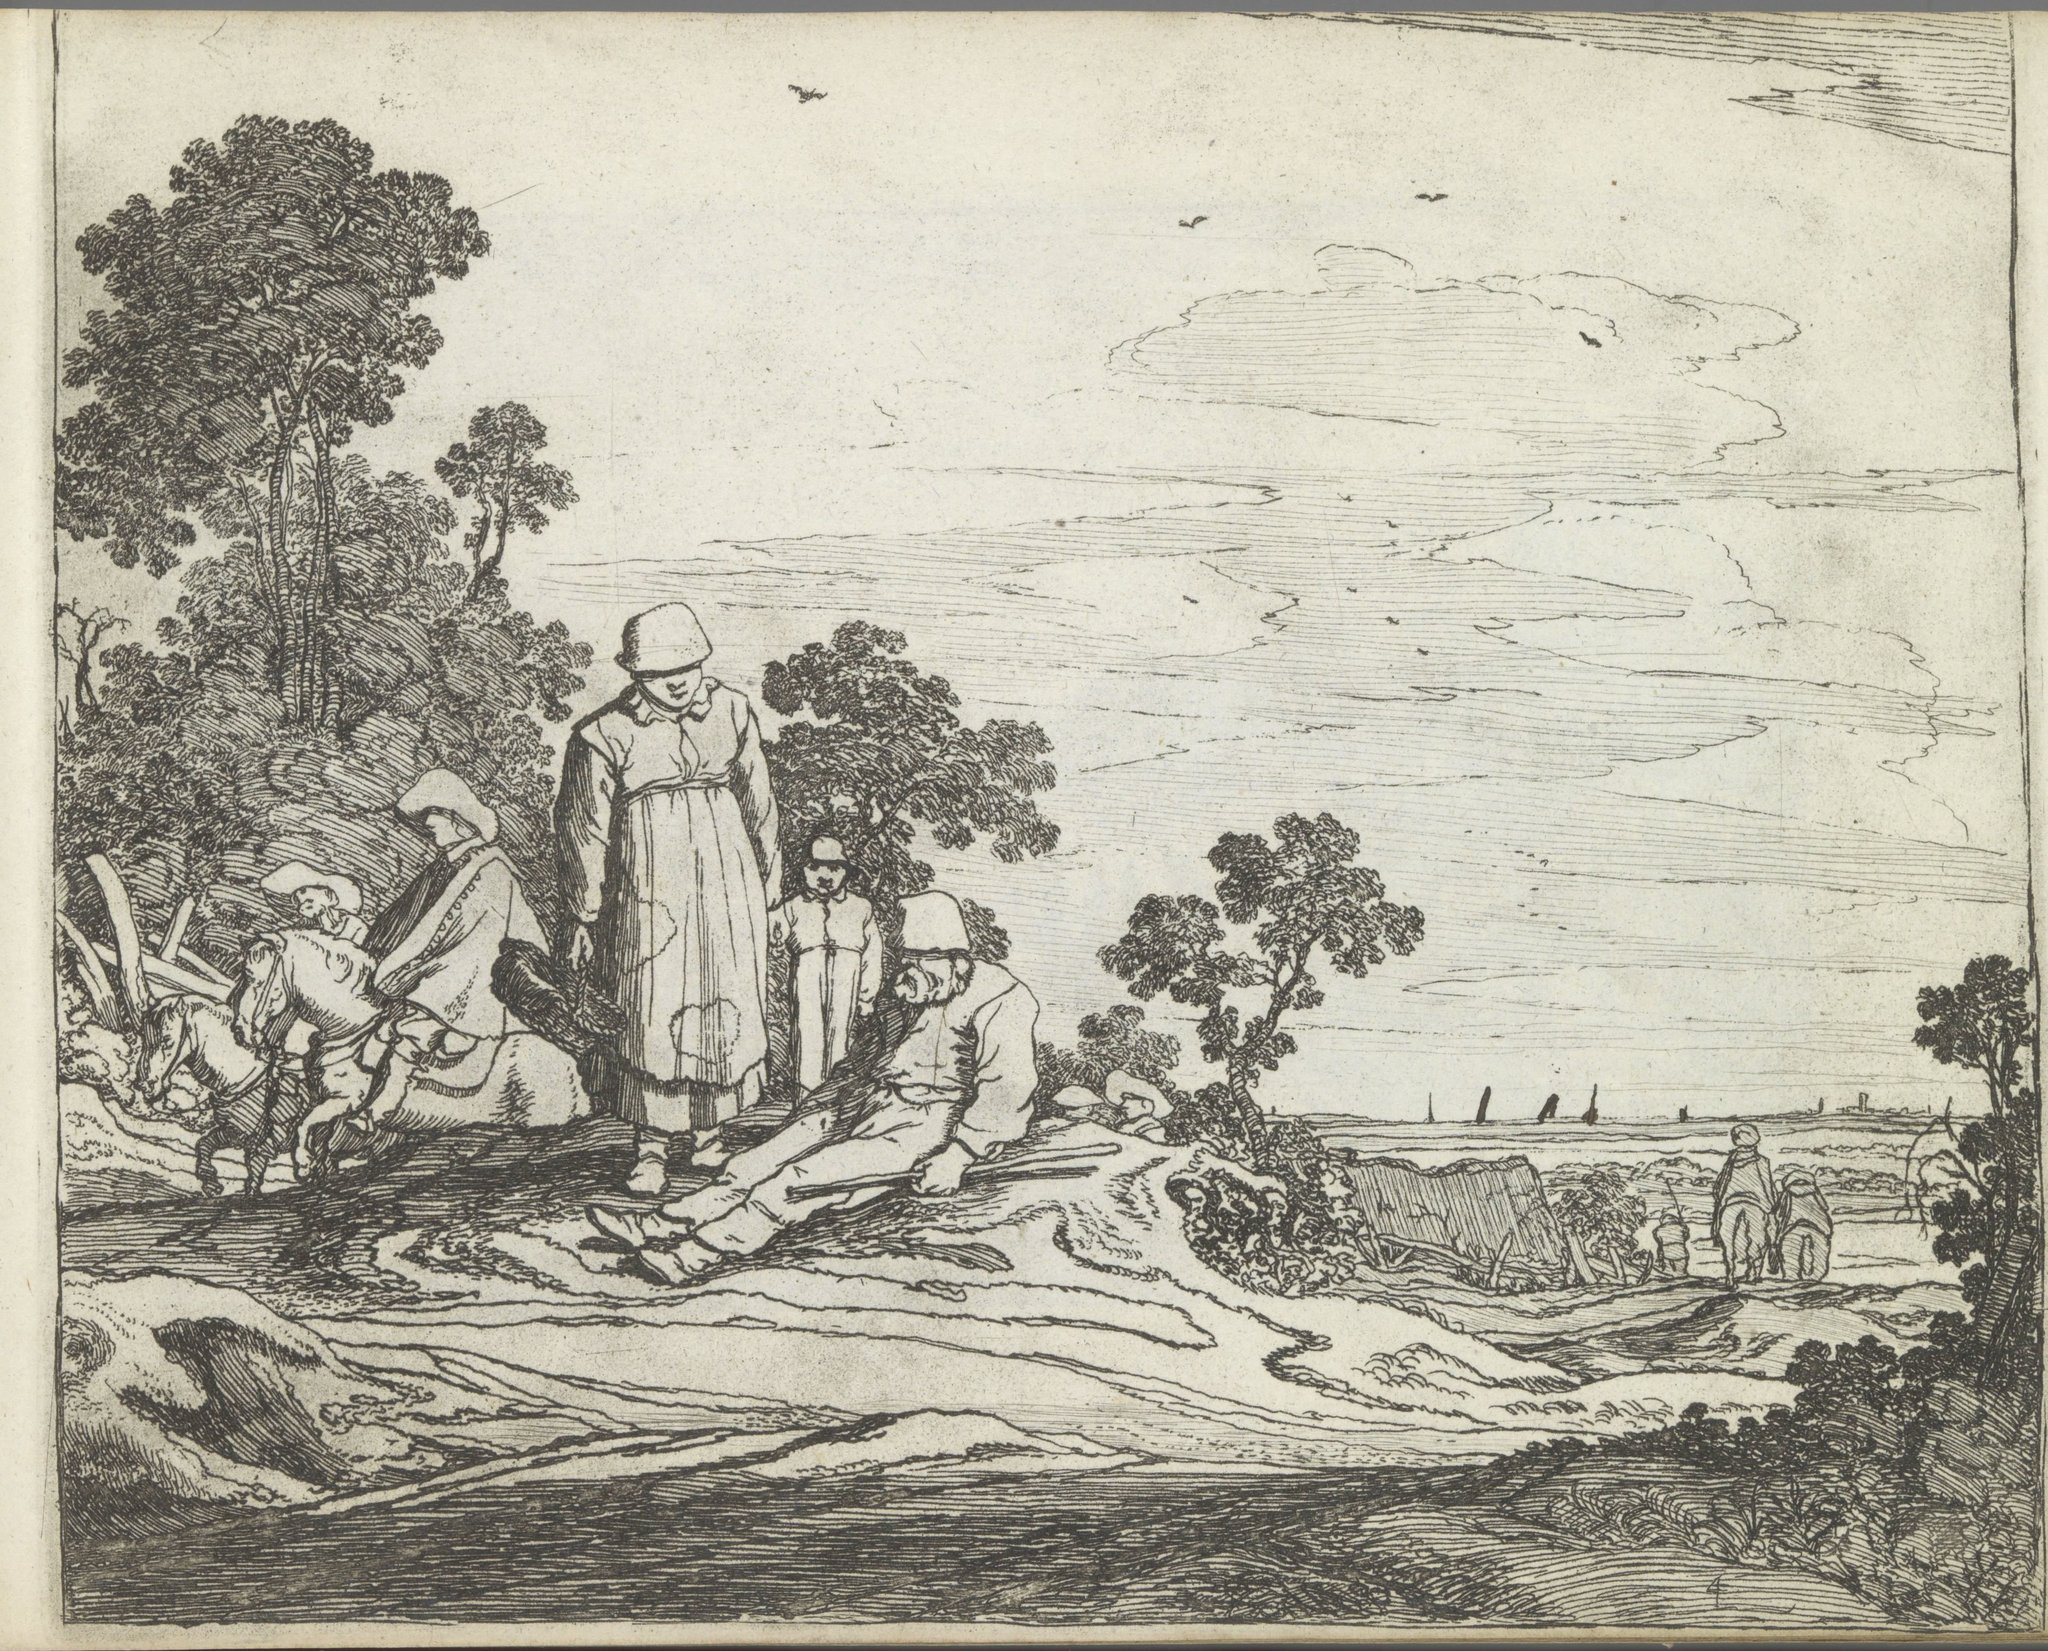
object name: print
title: Landschappen met figuren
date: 1626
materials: paper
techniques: etching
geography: amsterdam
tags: riding a horse, ass, or mule; rider, horseman, landscapes in the temperate zone, farmers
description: In een landelijke omgeving staat een boerin met een klein kind aan de hand bij een zittende oude man. Achter hen twee ruiters. De prent maakt deel uit van een album.